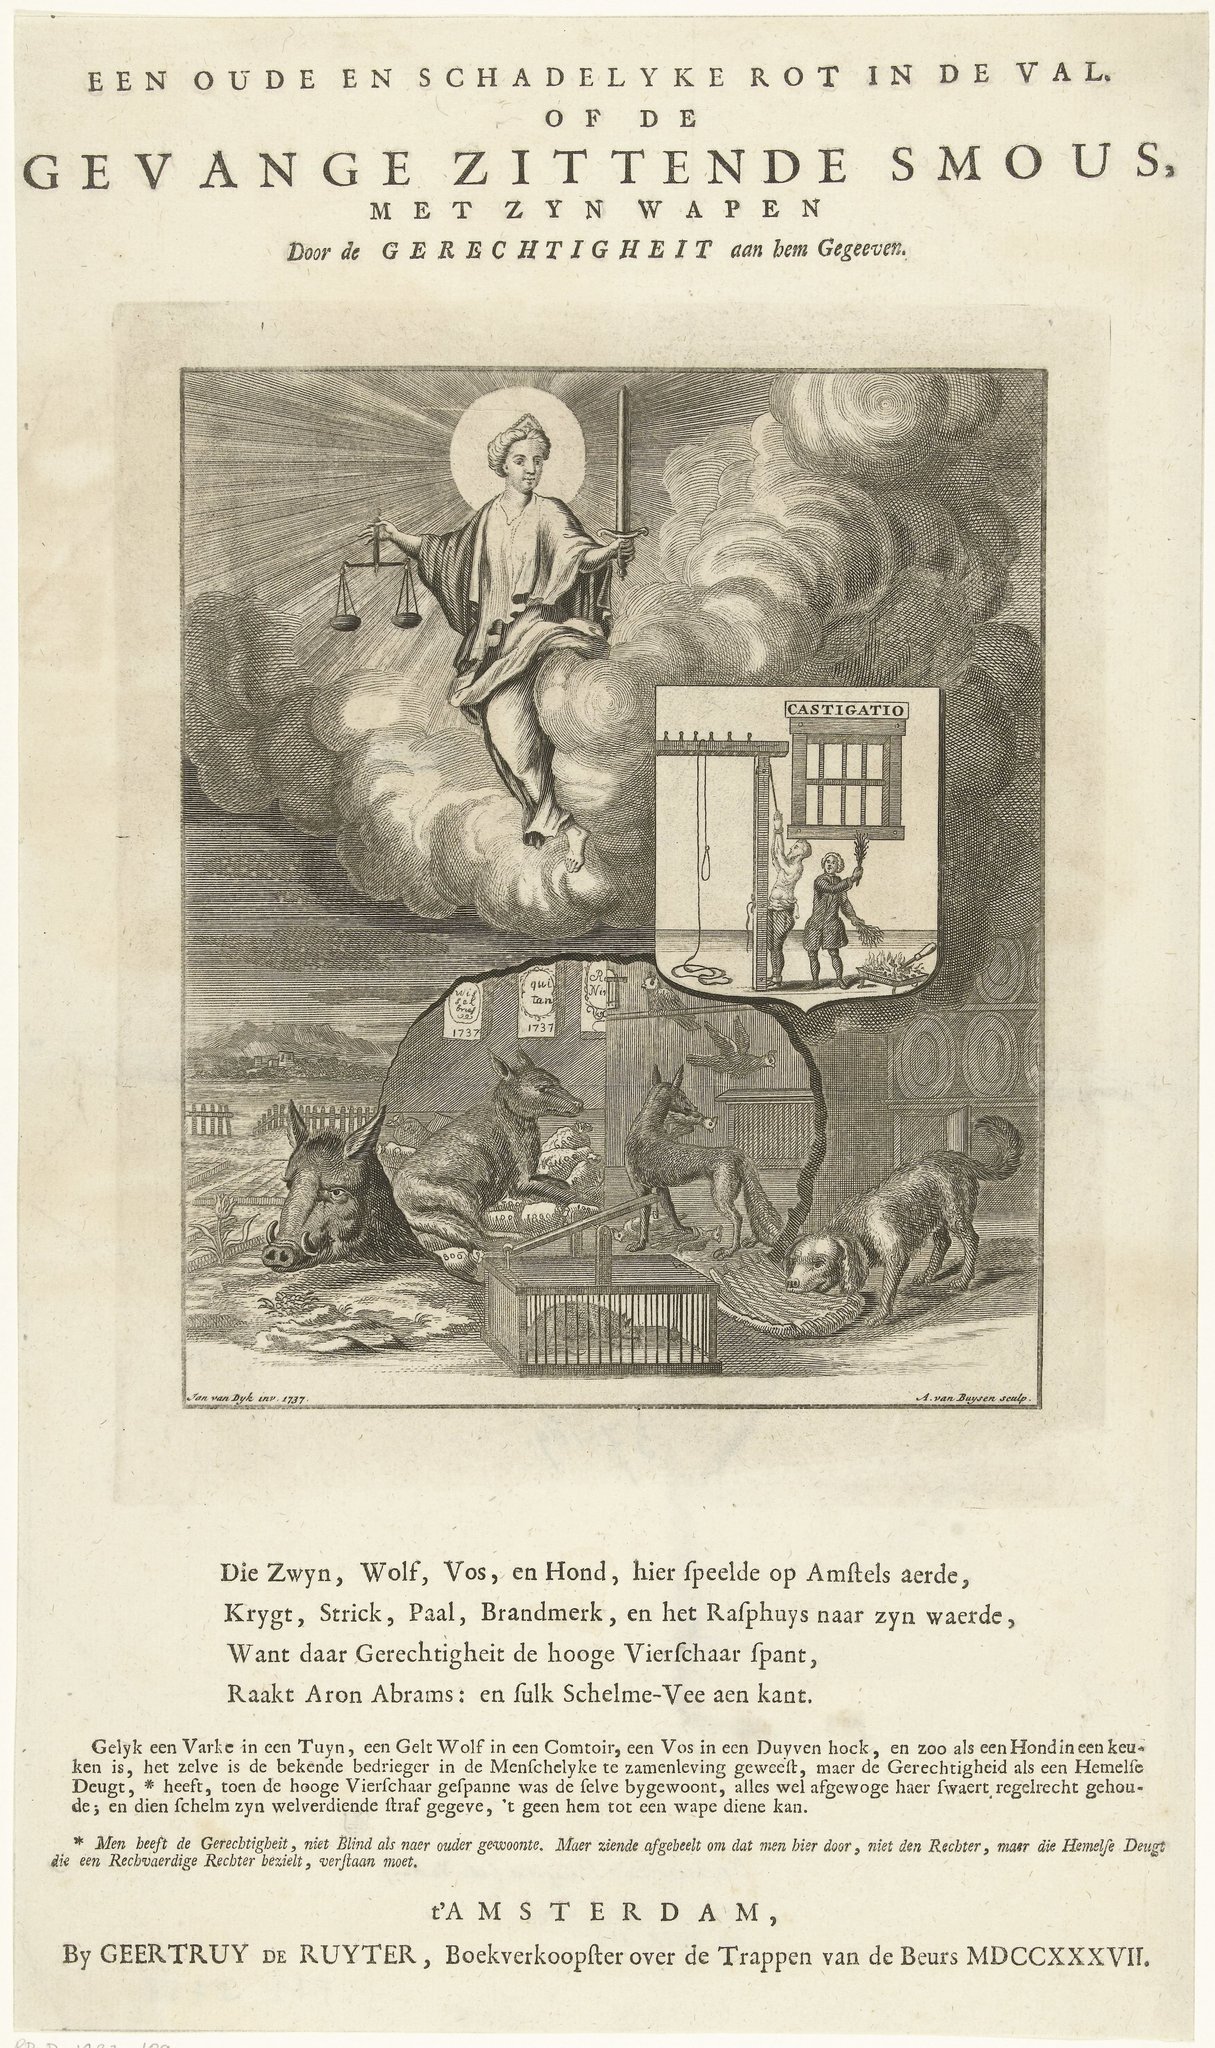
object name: cartoon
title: Allegorie op de berechting van de Amsterdamse bedrieger Aron Abrahams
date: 1737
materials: paper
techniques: engraving, etching, letterpress printing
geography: amsterdam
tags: amsterdam, rodents: rat, justice; 'forza alla giustitia sottoposta', 'giustitia', 'giustitia retta', 'giustitia rigorosa', 'impietà e violenza soggetta alla giustitia' (ripa), themis, dog with bone, instruments of torture, execution or punishment, beasts of prey, predatory animals: fox, beasts of prey, predatory animals: wolf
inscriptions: collector's mark: Lugt 2228, collector's mark: Lugt 2760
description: De Amsterdamse bedrieger Aron Abrams of Abrahams wordt gegeseld en gebrandmerkt. In de wolken Justitia met zwaard en weegschaal, maar zonder blinddoek. Onder vier dieren die symbool staan voor 'de slechte Jood' - een wroetend zwijn, een wolf in een bankkluis, een vos in een duiventil en een hond in de keuken. De rat in de val staat voor Abrahams zelf die nu gevangen zit. Onder de voorstelling een vers en tekst met uitleg over de prent.